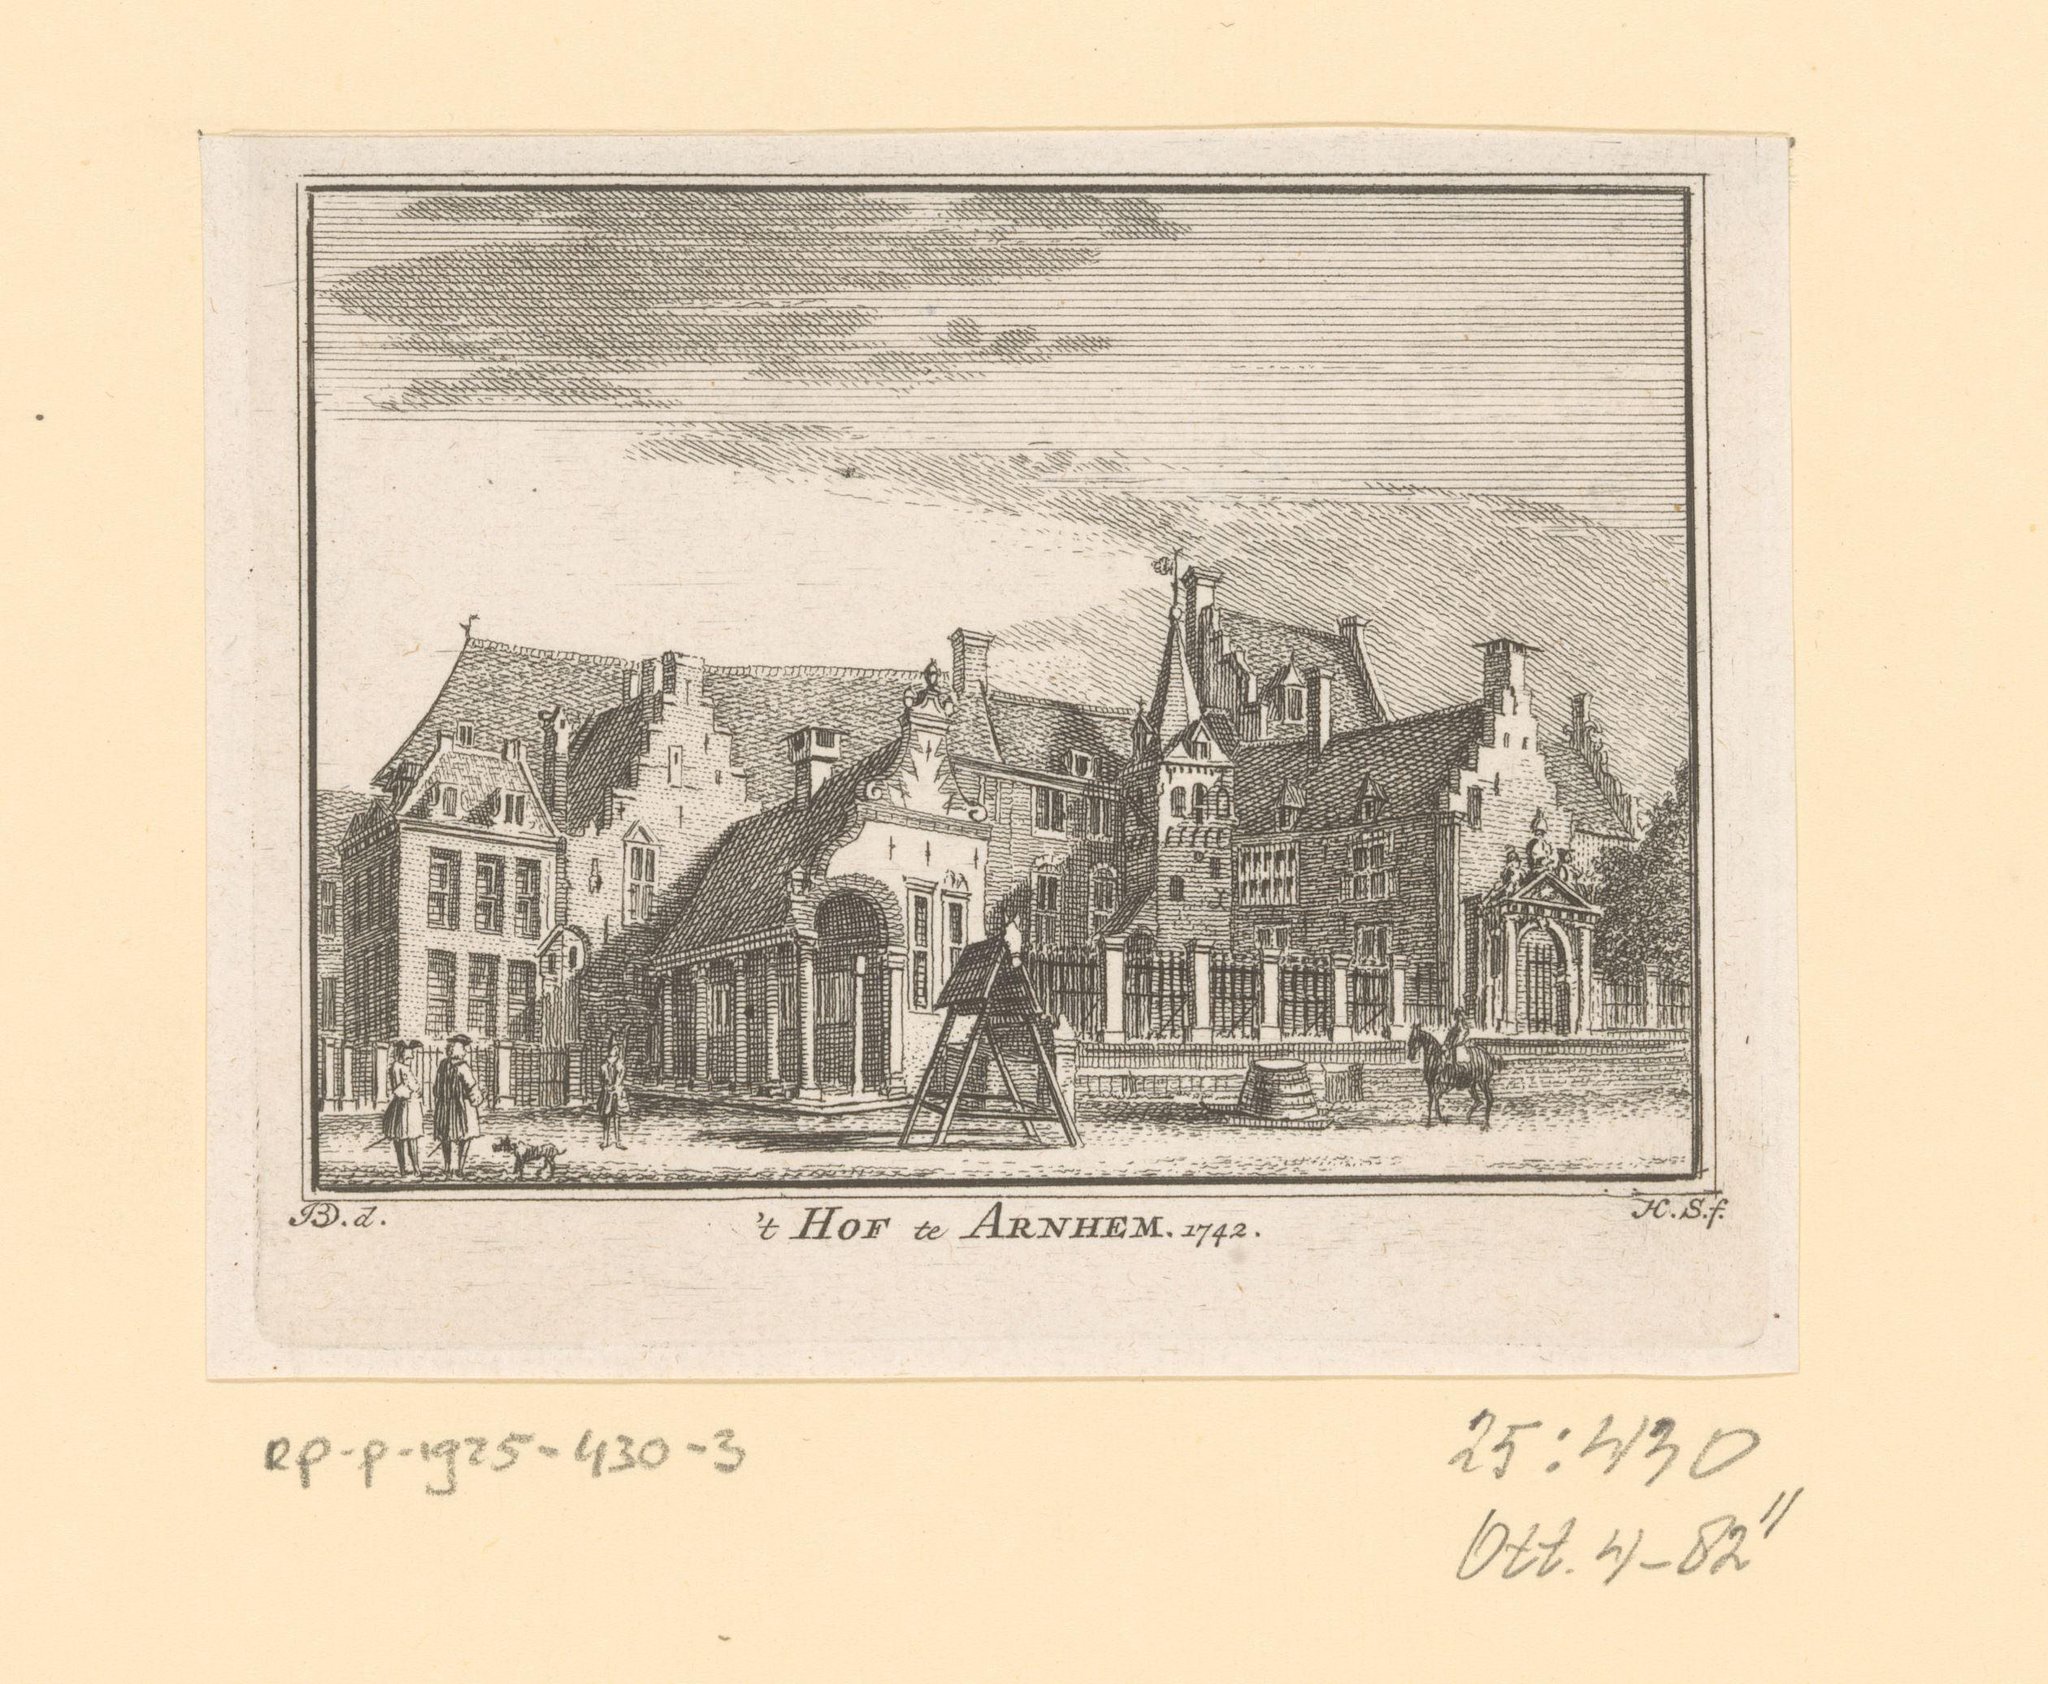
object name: print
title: Gezichten in Nederland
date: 1745-1774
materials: paper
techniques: etching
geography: amsterdam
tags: castle, arnhem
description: Prent gebruikt in: Het verheerlykt Nederland of kabinet van hedendaagsche gezigten van steden, dorpen (…). 9 dln. Amsterdam: Isaak Tirion, 1745-1774.